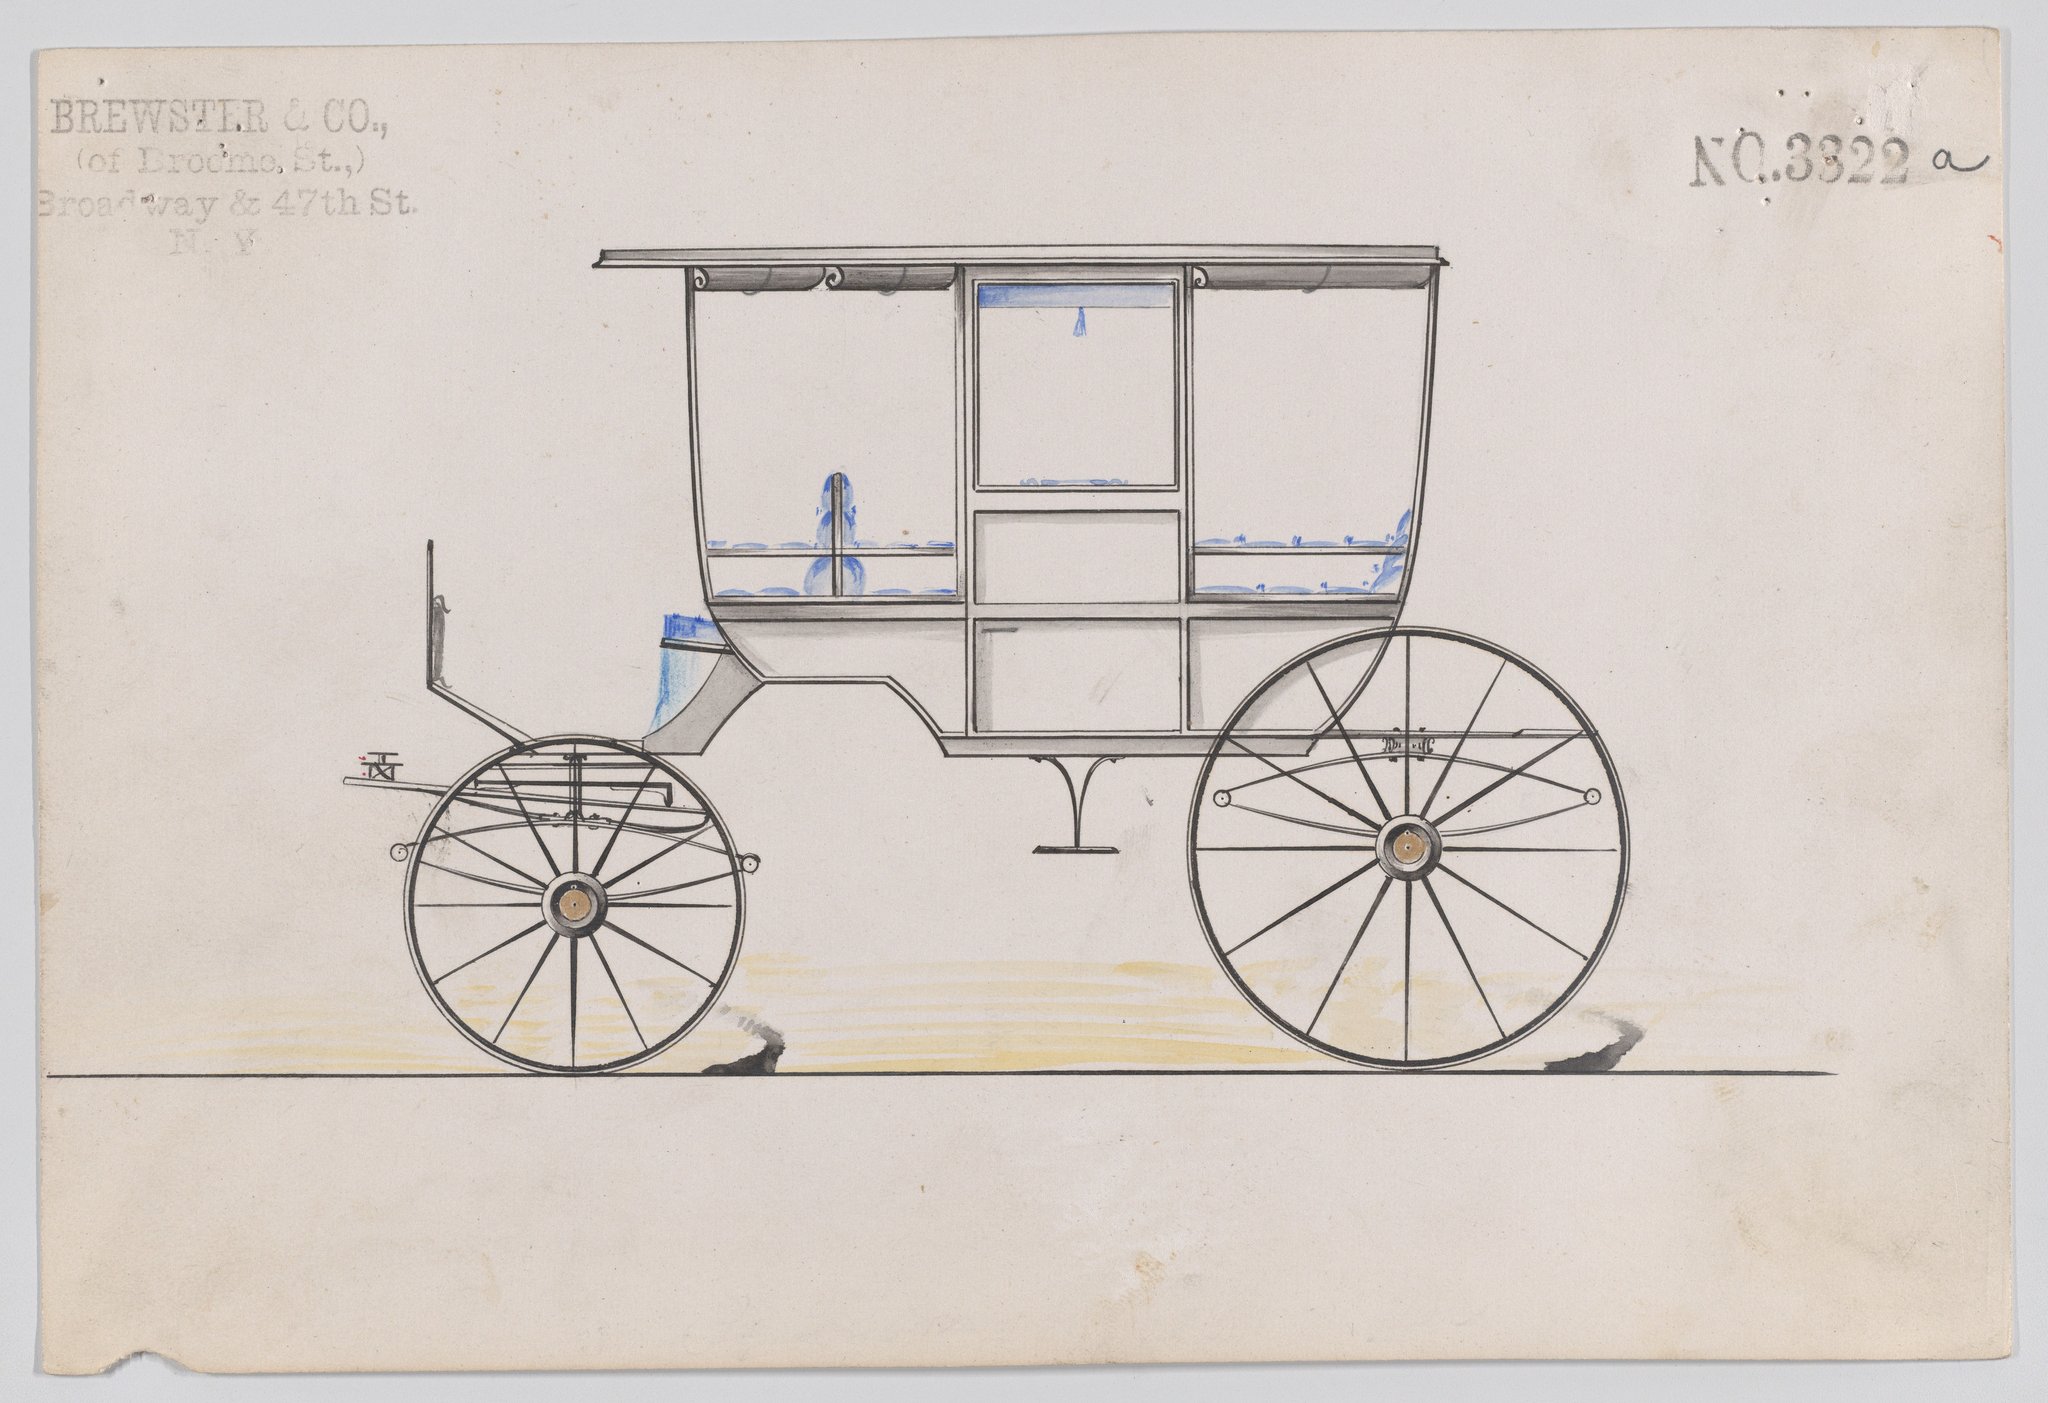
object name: drawing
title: Design for 6 seat Rockaway, no. 3322a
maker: brewster & co.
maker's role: manufacturer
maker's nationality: american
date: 1877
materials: gouache, gum arabic, ink, watercolor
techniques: pen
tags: carriages